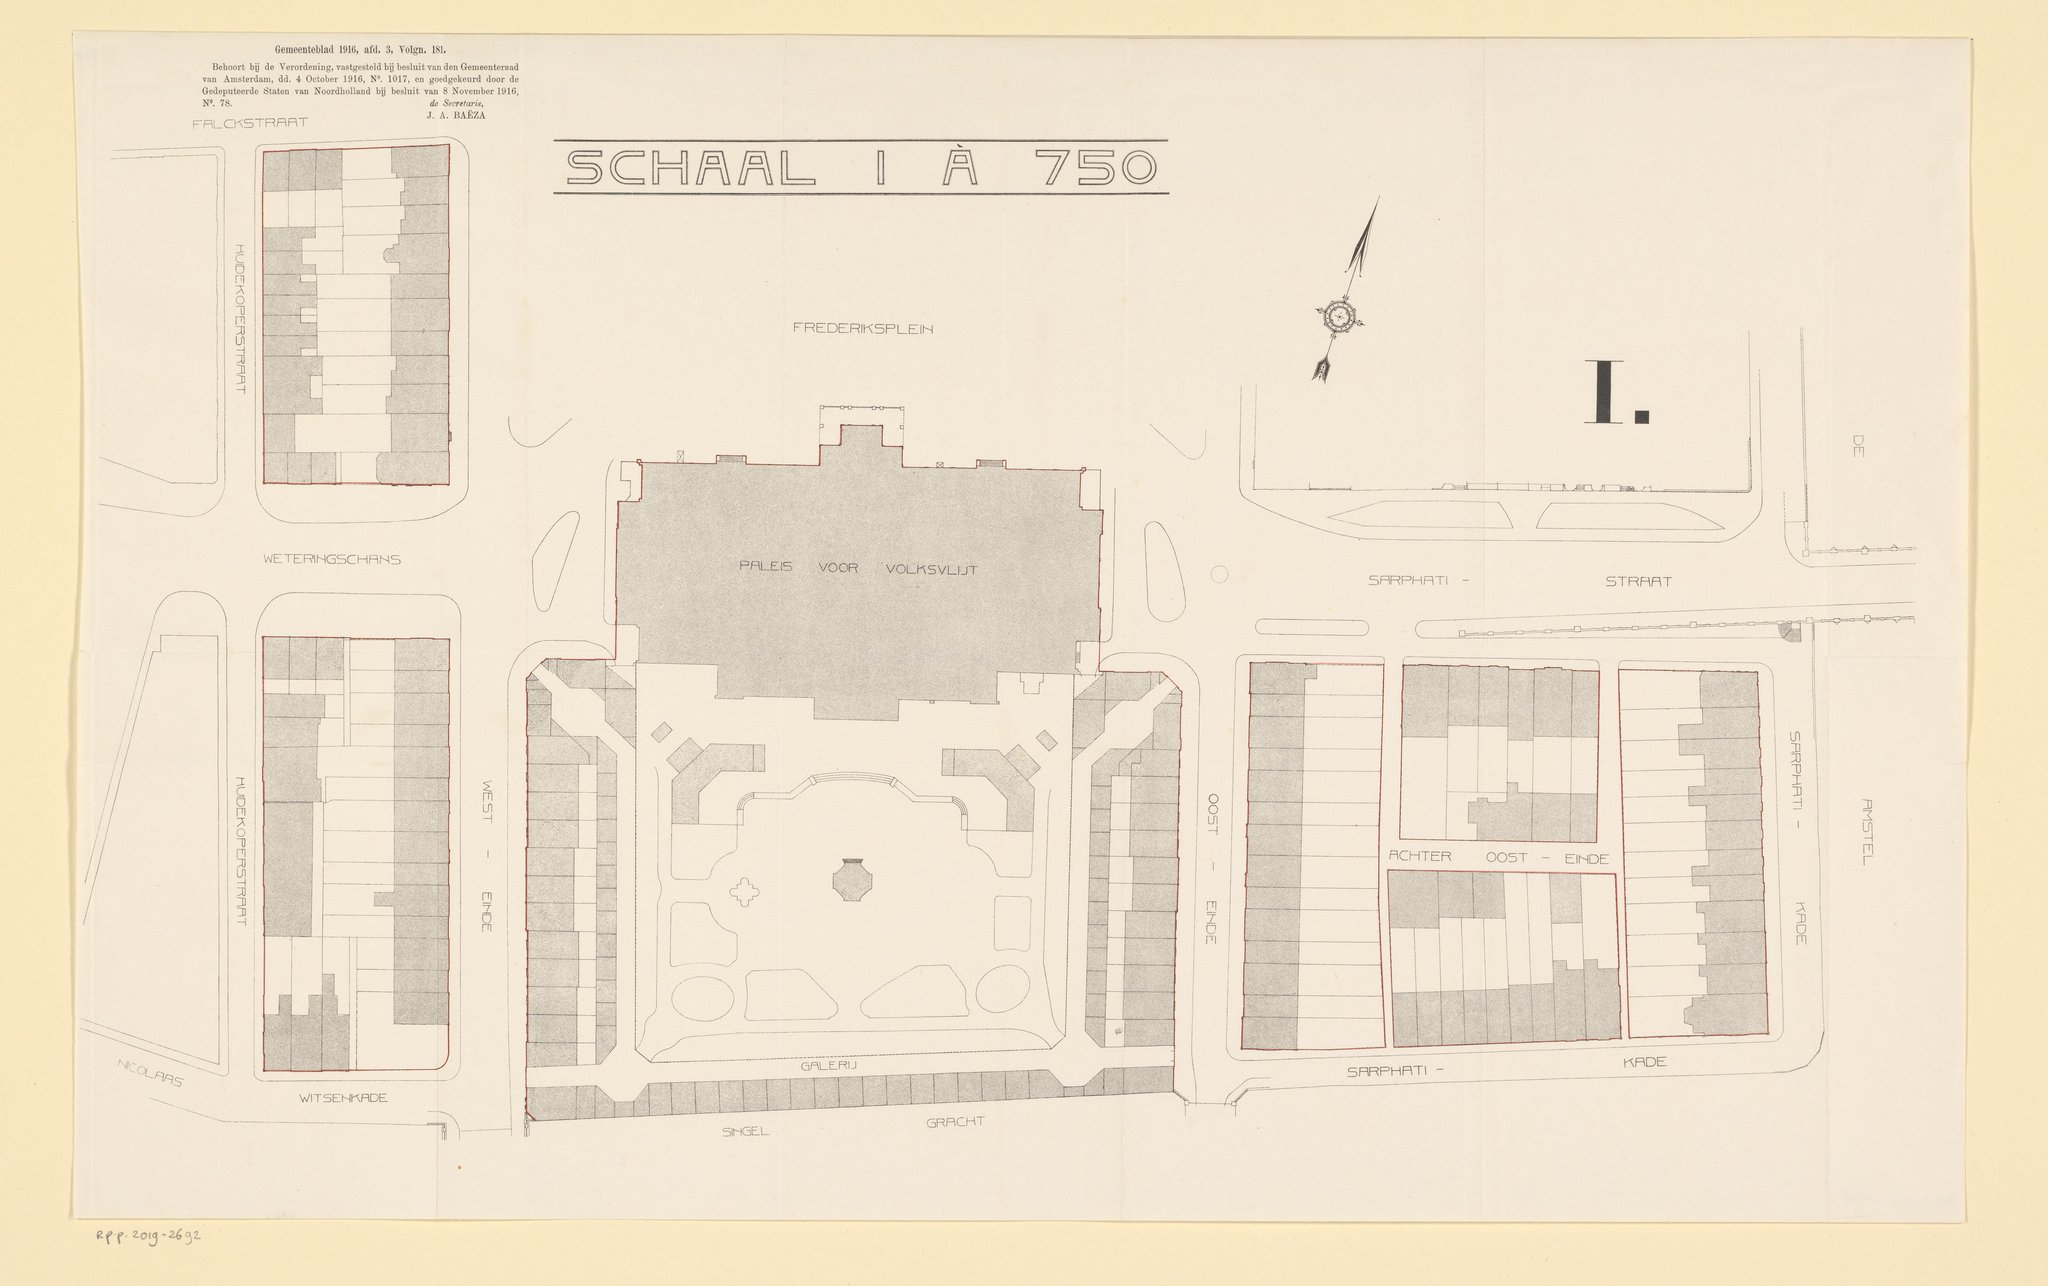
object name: area plan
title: Plattegrond van het Paleis voor Volksvlijt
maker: Anonymous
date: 1916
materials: paper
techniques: lithograph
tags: maps, atlases, amsterdam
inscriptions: date